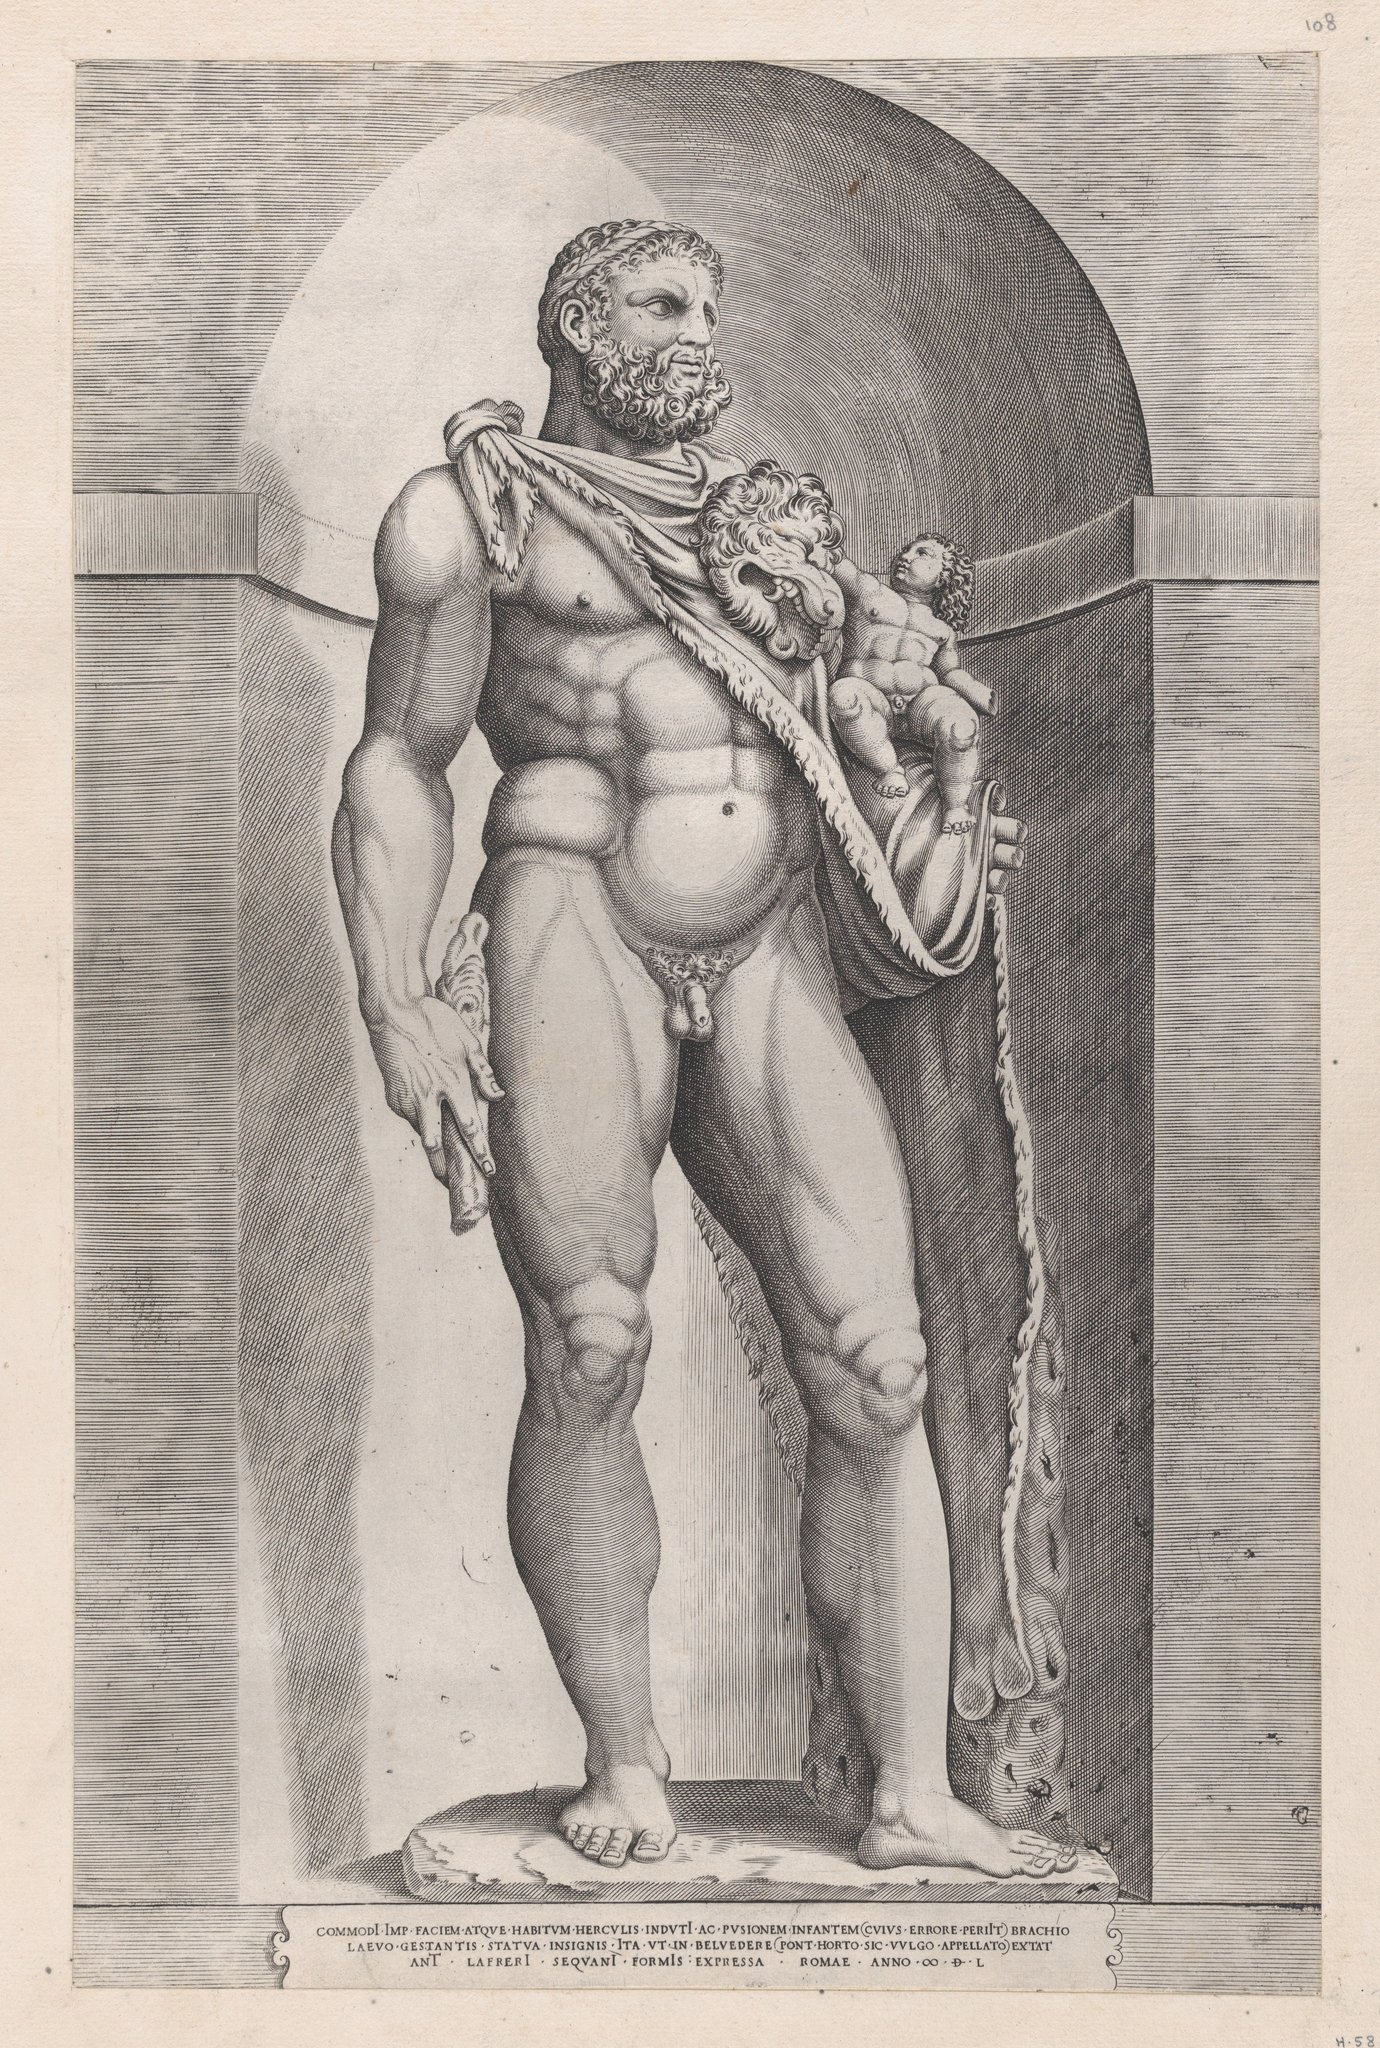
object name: print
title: Emperor Commodus as Hercules, from "Speculum Romanae Magnificentiae"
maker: jacob bos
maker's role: artist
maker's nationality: netherlandish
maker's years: 1520-1580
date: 1550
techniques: engraving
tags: children,male nudes